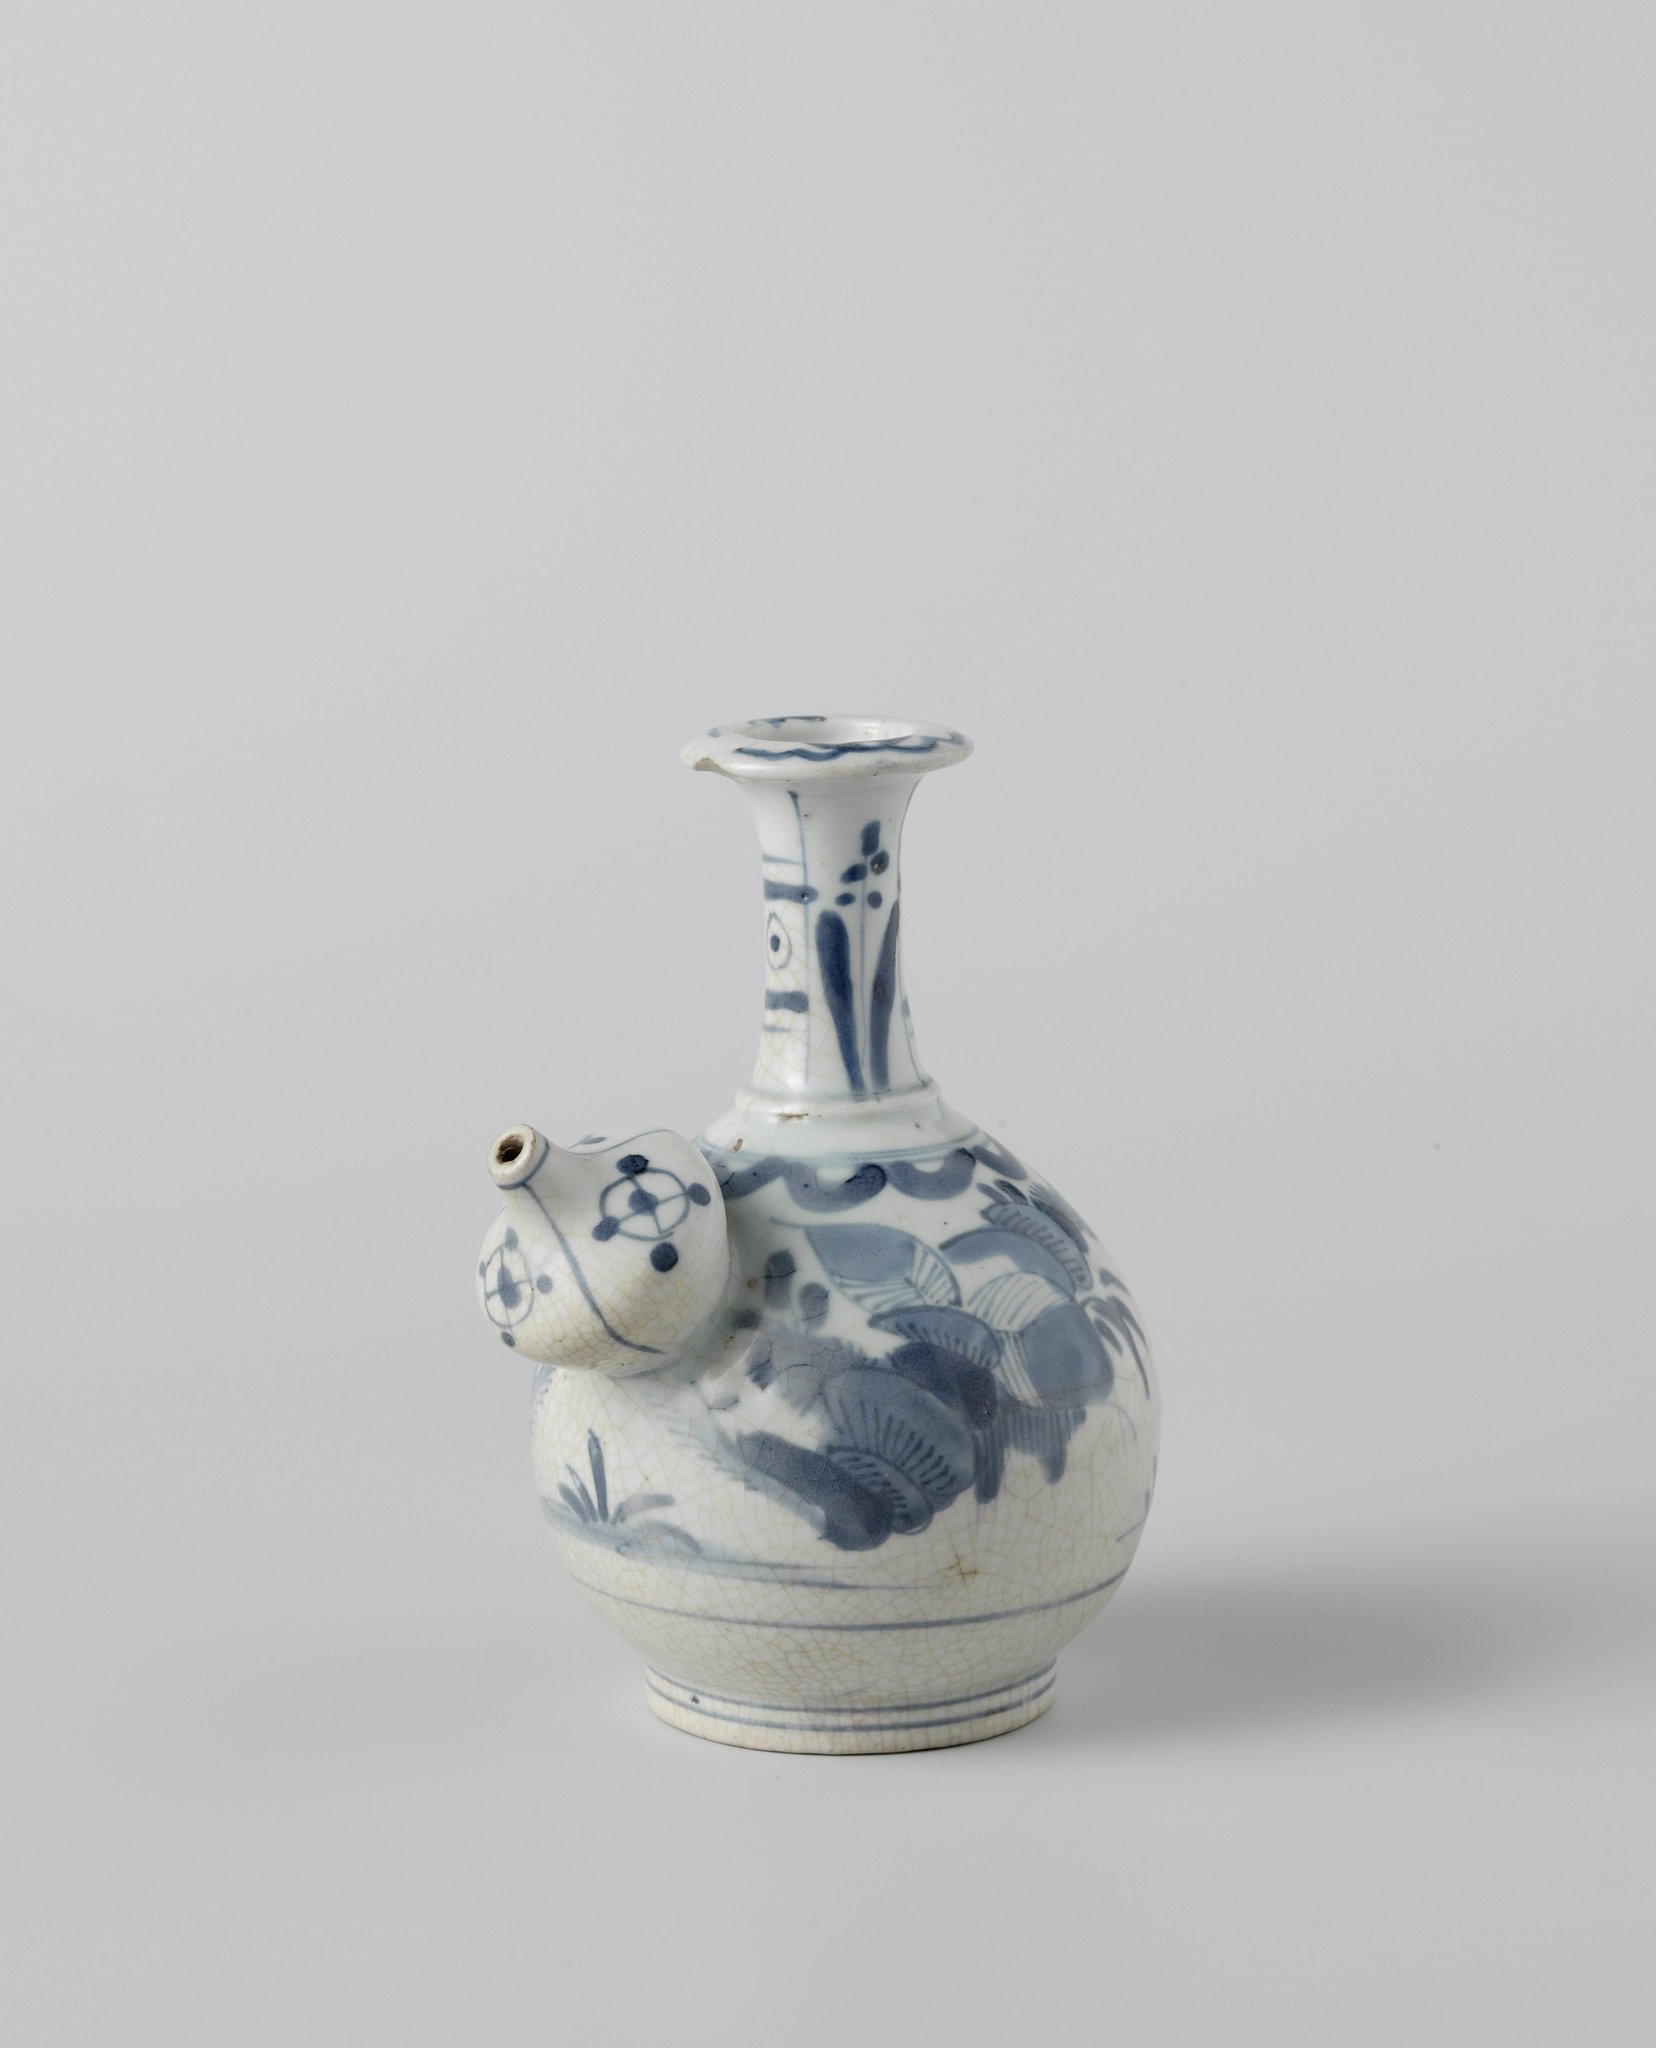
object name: kendi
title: Kendi with flower sprays and a landscape with rocks and plants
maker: Anonymous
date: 1600-1699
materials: cobalt, glaze, paint, porcelain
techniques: firing, turning, vitrification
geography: japan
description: Kendi. Japan, Arita ca. 1660-1680. Porcelain, decoration in underglaze blue.